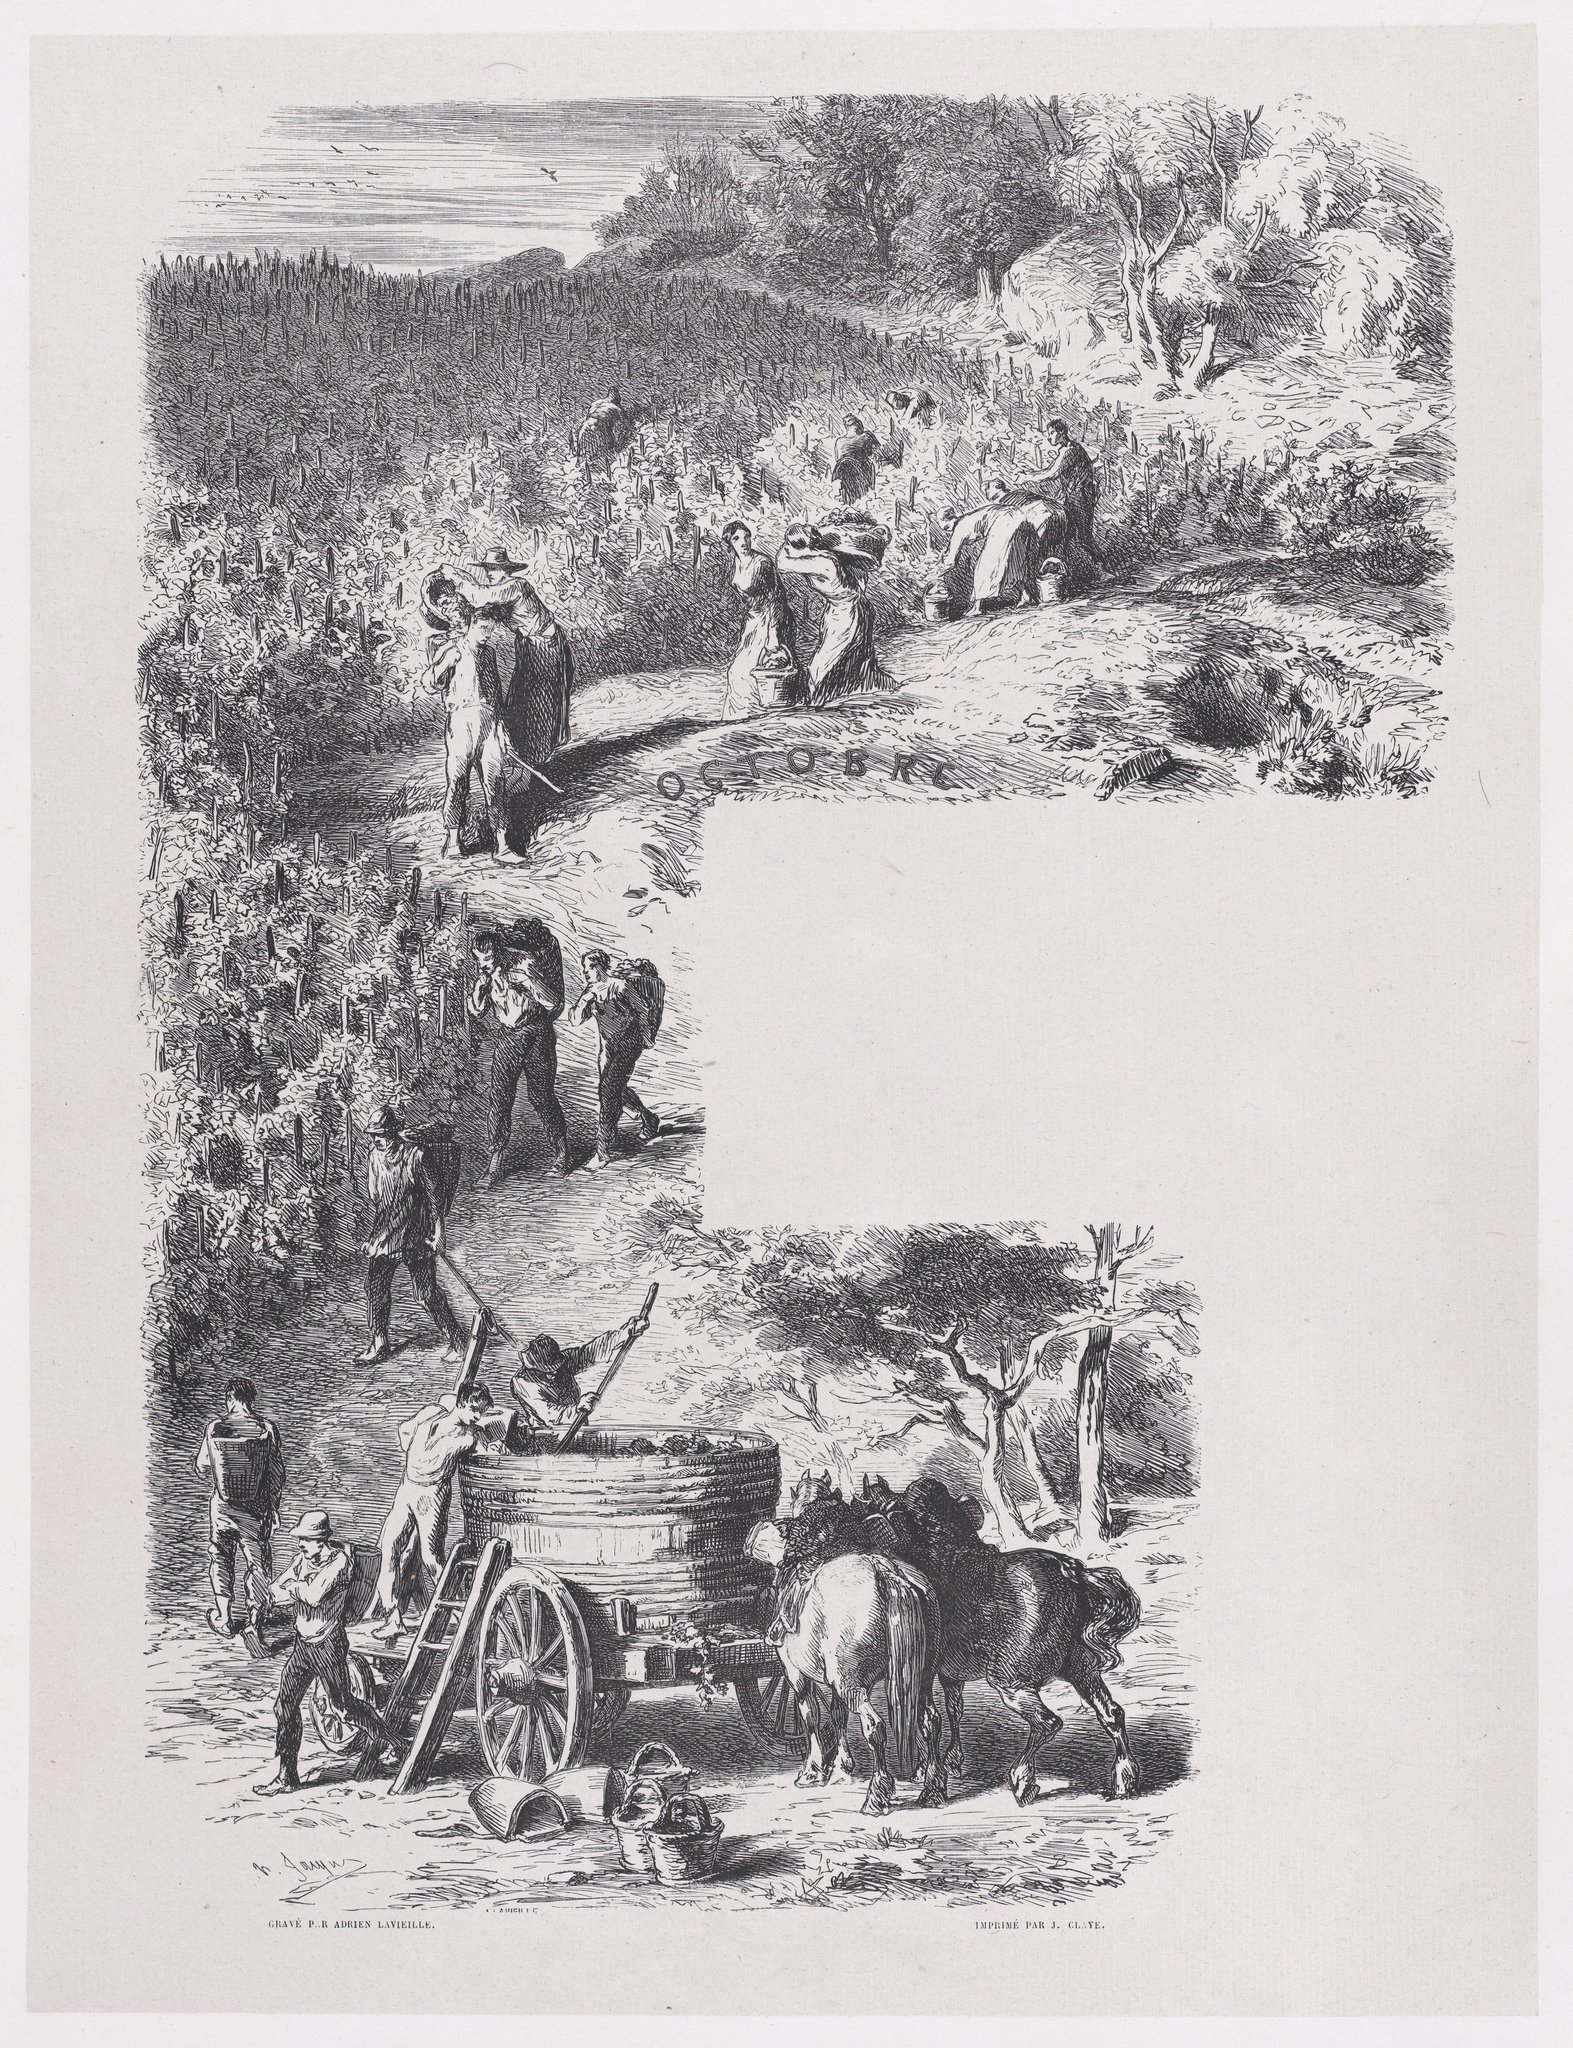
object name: print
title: October, from "Album of Rustic Subjects"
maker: charles émile jacque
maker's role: artist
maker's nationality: french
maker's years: 1813-1894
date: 1859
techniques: engraving